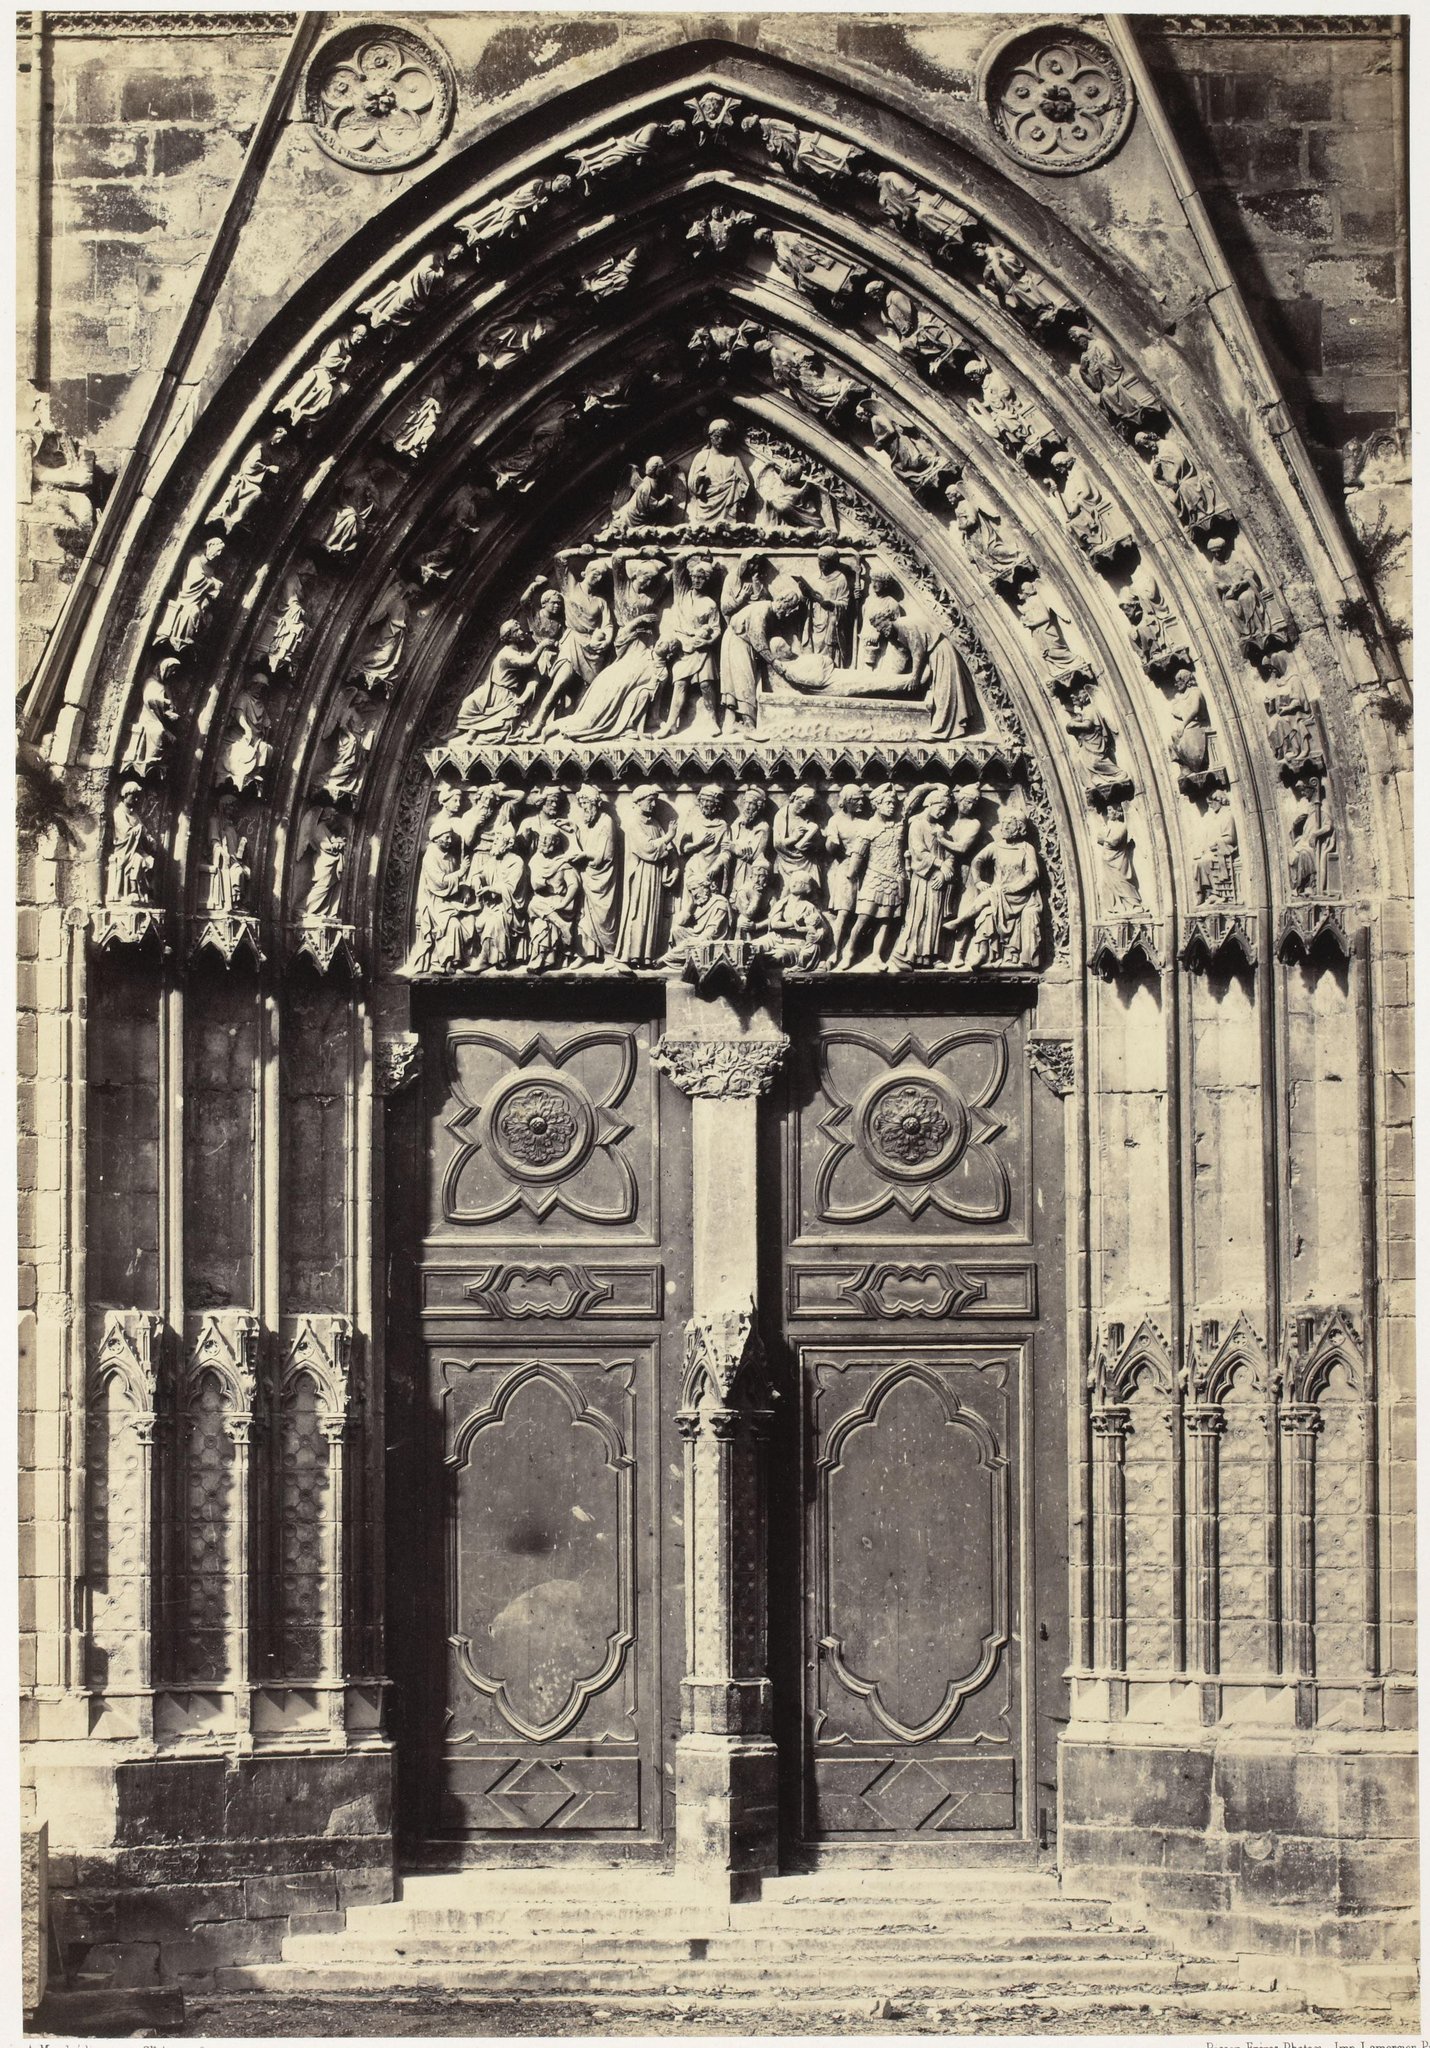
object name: photograph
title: Deuren van het transcept aan de zuidzijde van de Notre Dame, Parijs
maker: a. morel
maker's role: publisher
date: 1853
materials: cardboard, paper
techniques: albumen print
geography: paris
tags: parts of church exterior and annexes: portal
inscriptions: stamp: ‘Bibliotheek/ Rijksmuseum/ Amsterdam’